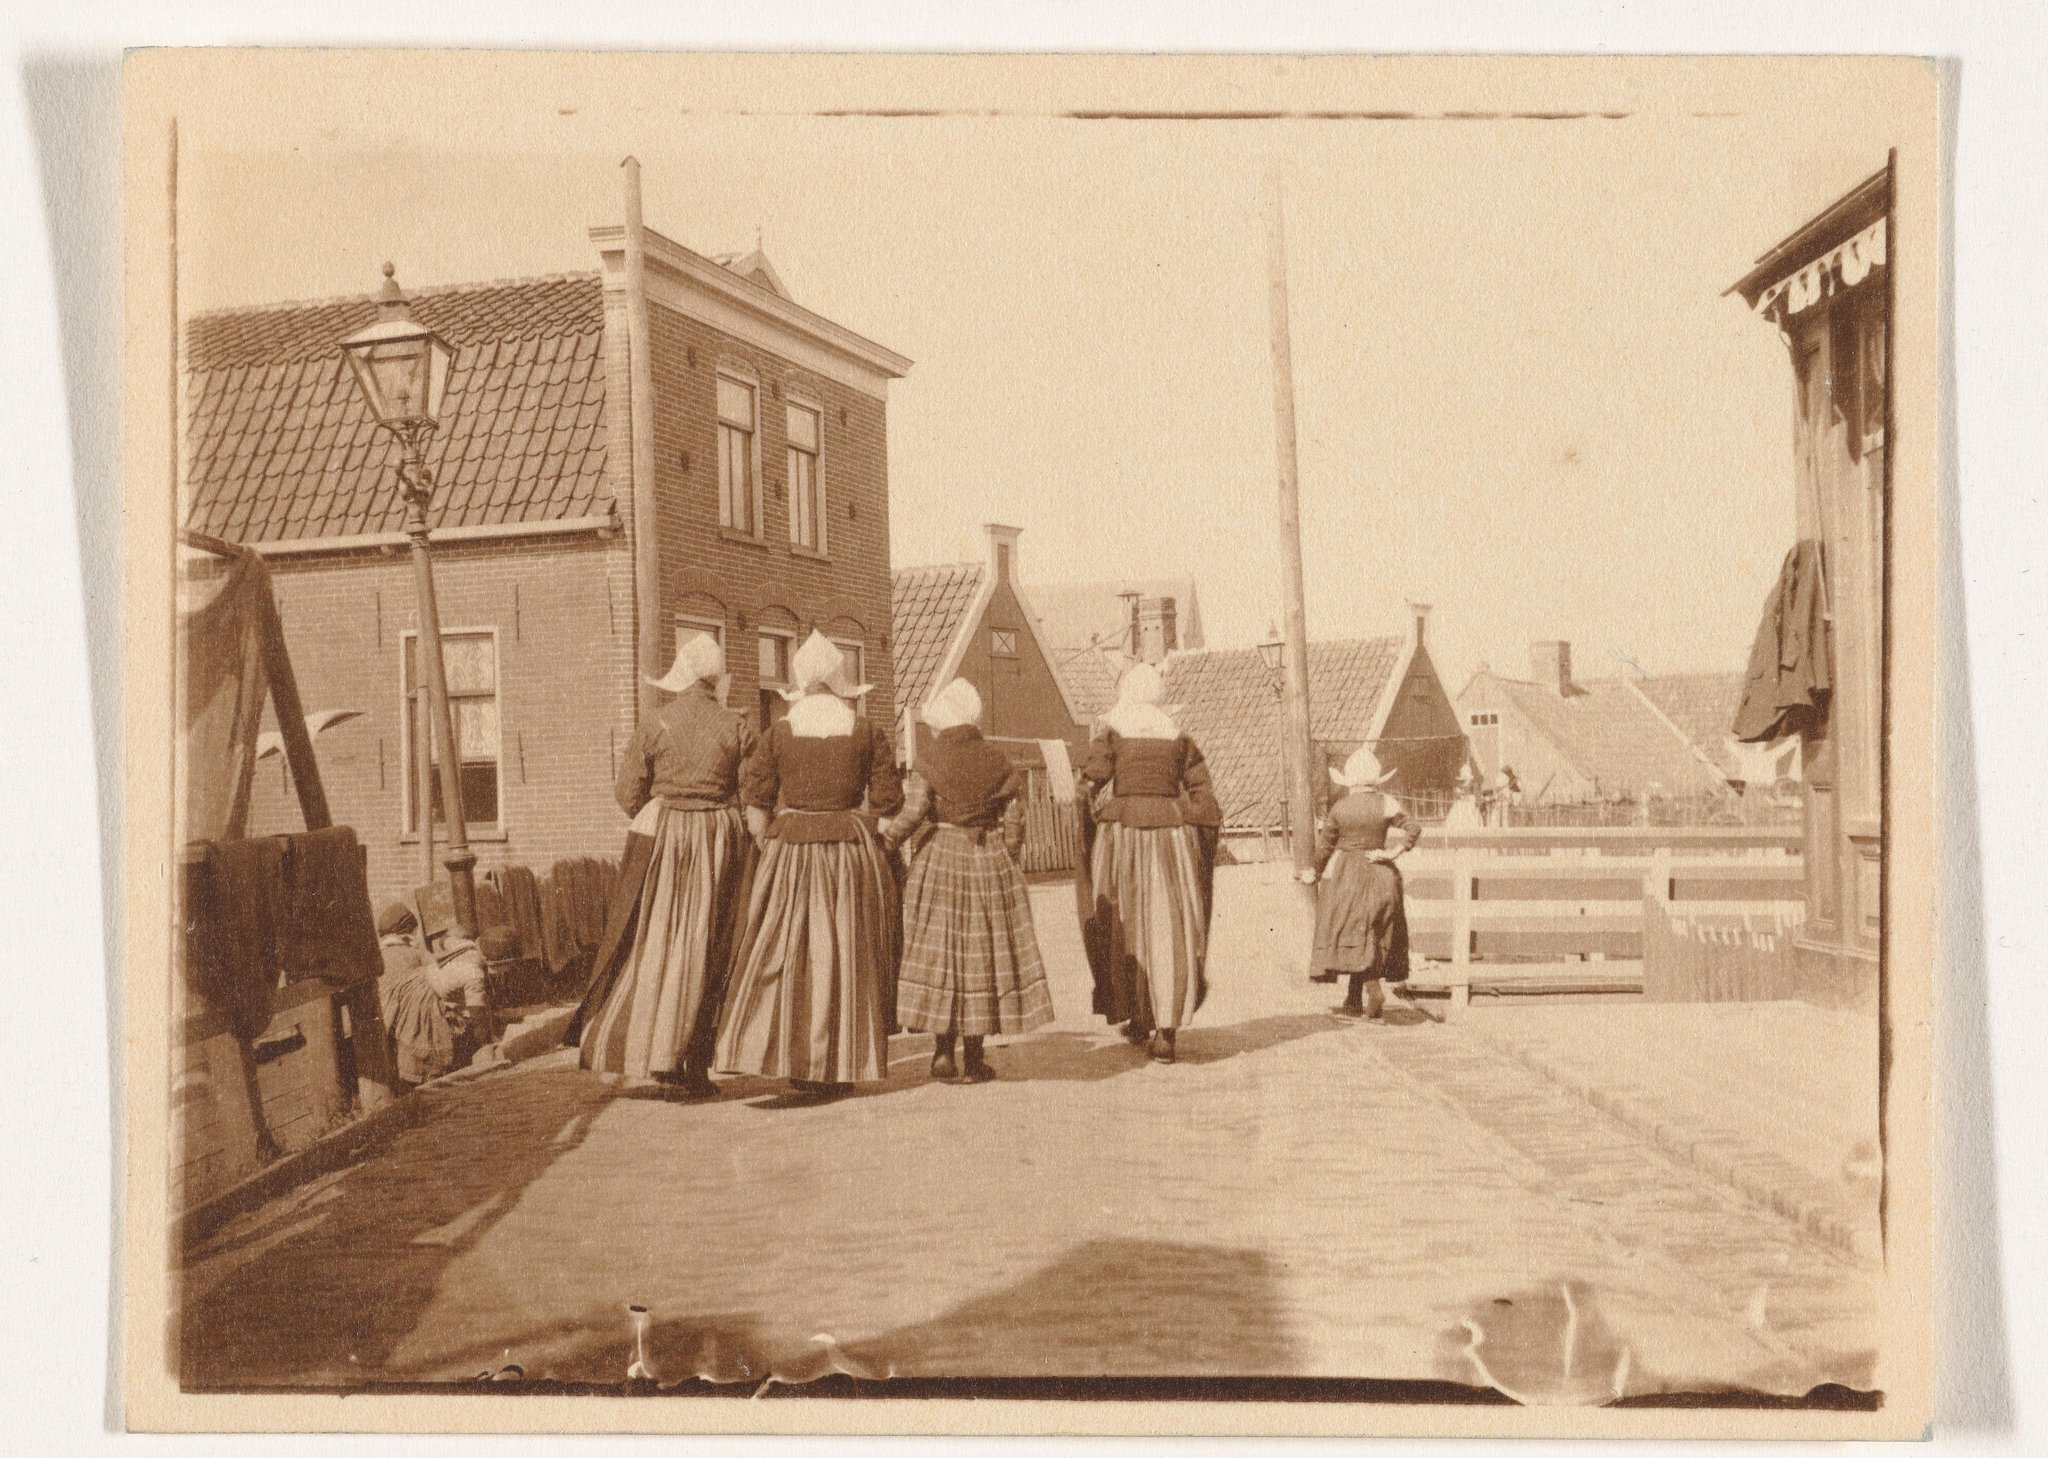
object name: photograph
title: Vrouwen en kinderen in klederdracht in Volendam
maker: george hidderley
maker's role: fotograaf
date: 1900-1910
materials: photographic support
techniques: salted paper print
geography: volendam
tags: adult woman, child, folk costume, regional costume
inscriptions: number: ‘13’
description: Was oorspronkelijk los ingevoegd in album RP-F-2002-105